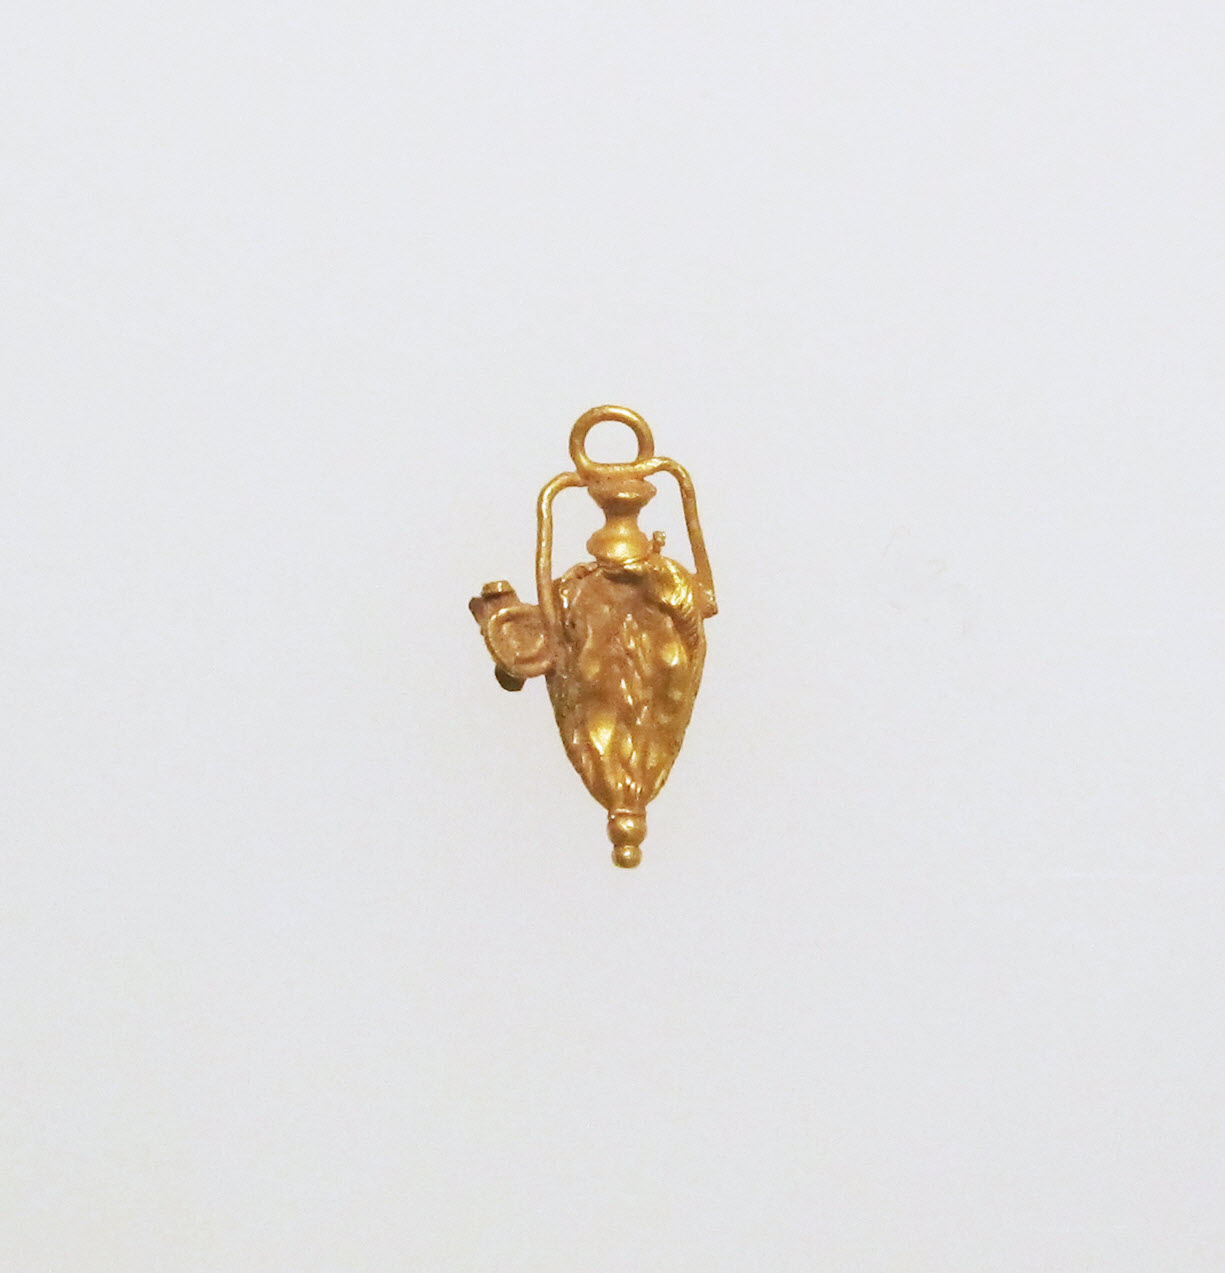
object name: pendant in the form of a vase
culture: etruscan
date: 900-100 BCE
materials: gold